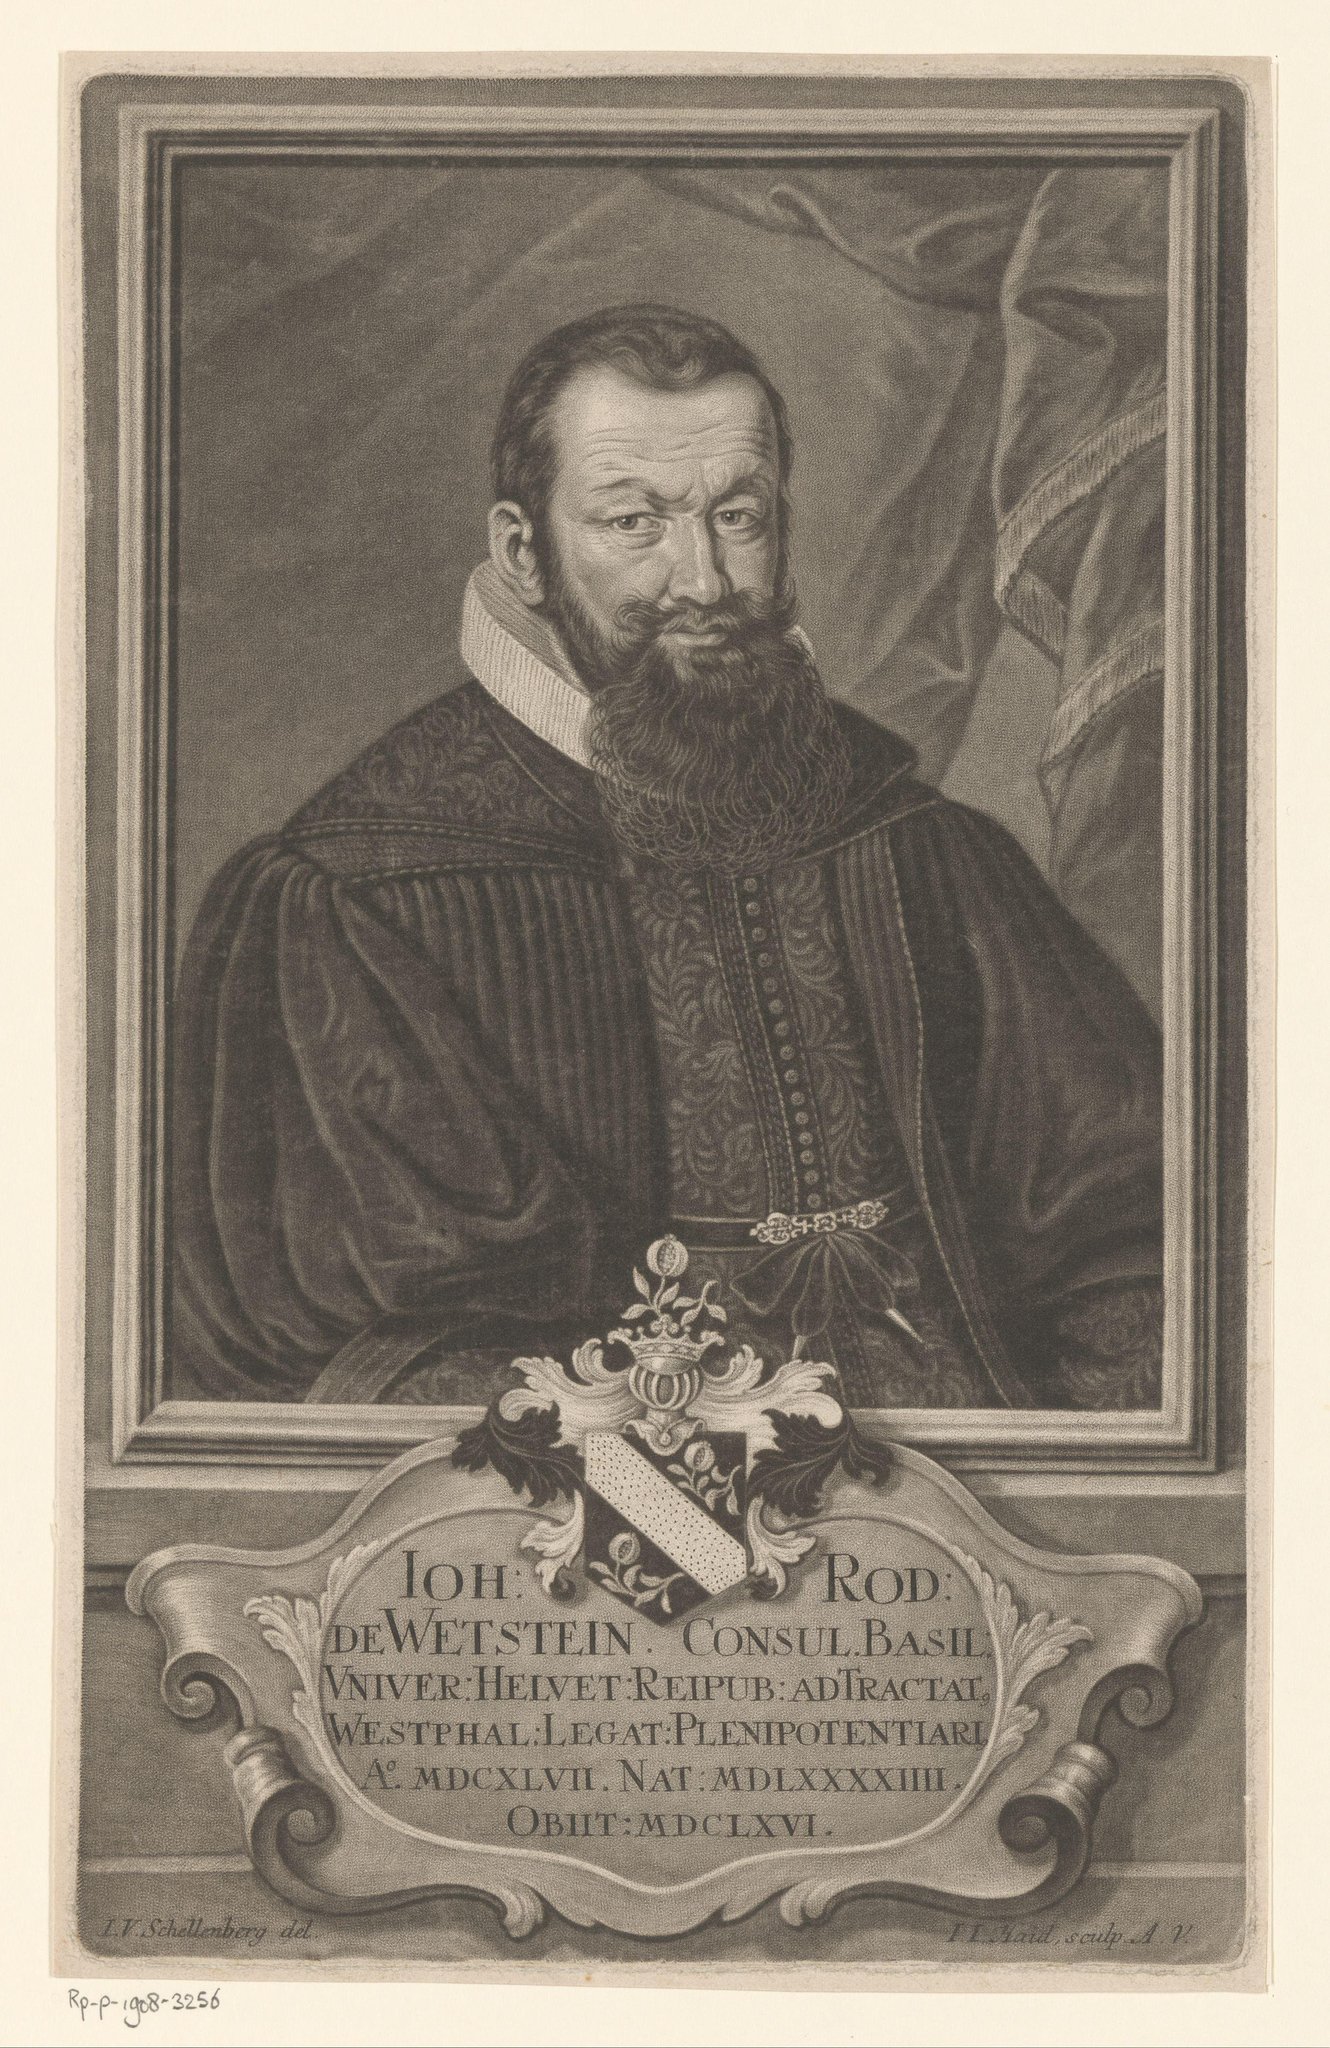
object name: print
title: Portret van Johann Rudolf Wettstein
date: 1719-1767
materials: paper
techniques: mezzotint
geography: augsburg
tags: historical persons, ornament ~ cartouche, armorial bearing, heraldry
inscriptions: collector's mark: Lugt 2228